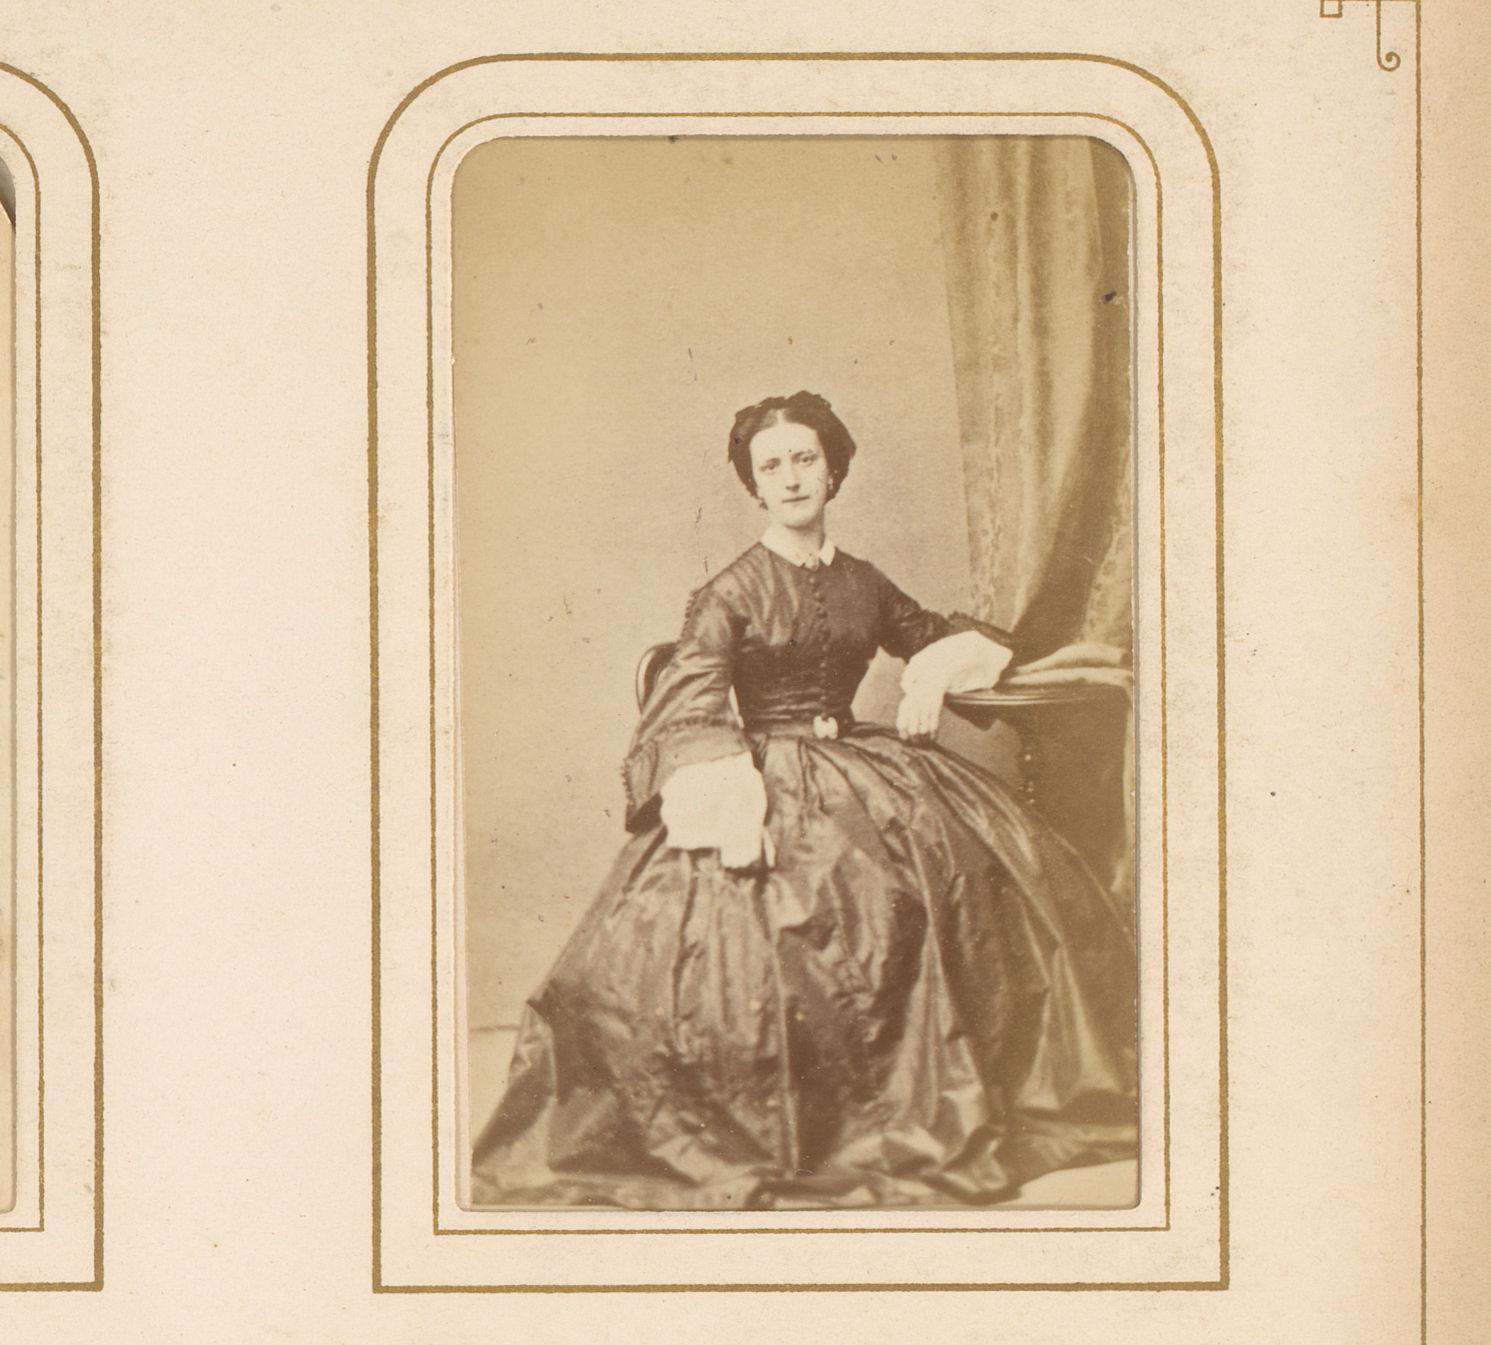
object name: photograph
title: Portret van een zittende vrouw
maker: eugene guérin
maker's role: fotograaf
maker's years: 1845-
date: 1875-1885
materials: cardboard, photographic support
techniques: albumen print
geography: brussels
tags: sitting figure - aa - female human figure, historical persons - bb - woman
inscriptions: inscription: ‘Eugène Guérin/ 142, Rue Royale, 142/ Bruxelles’